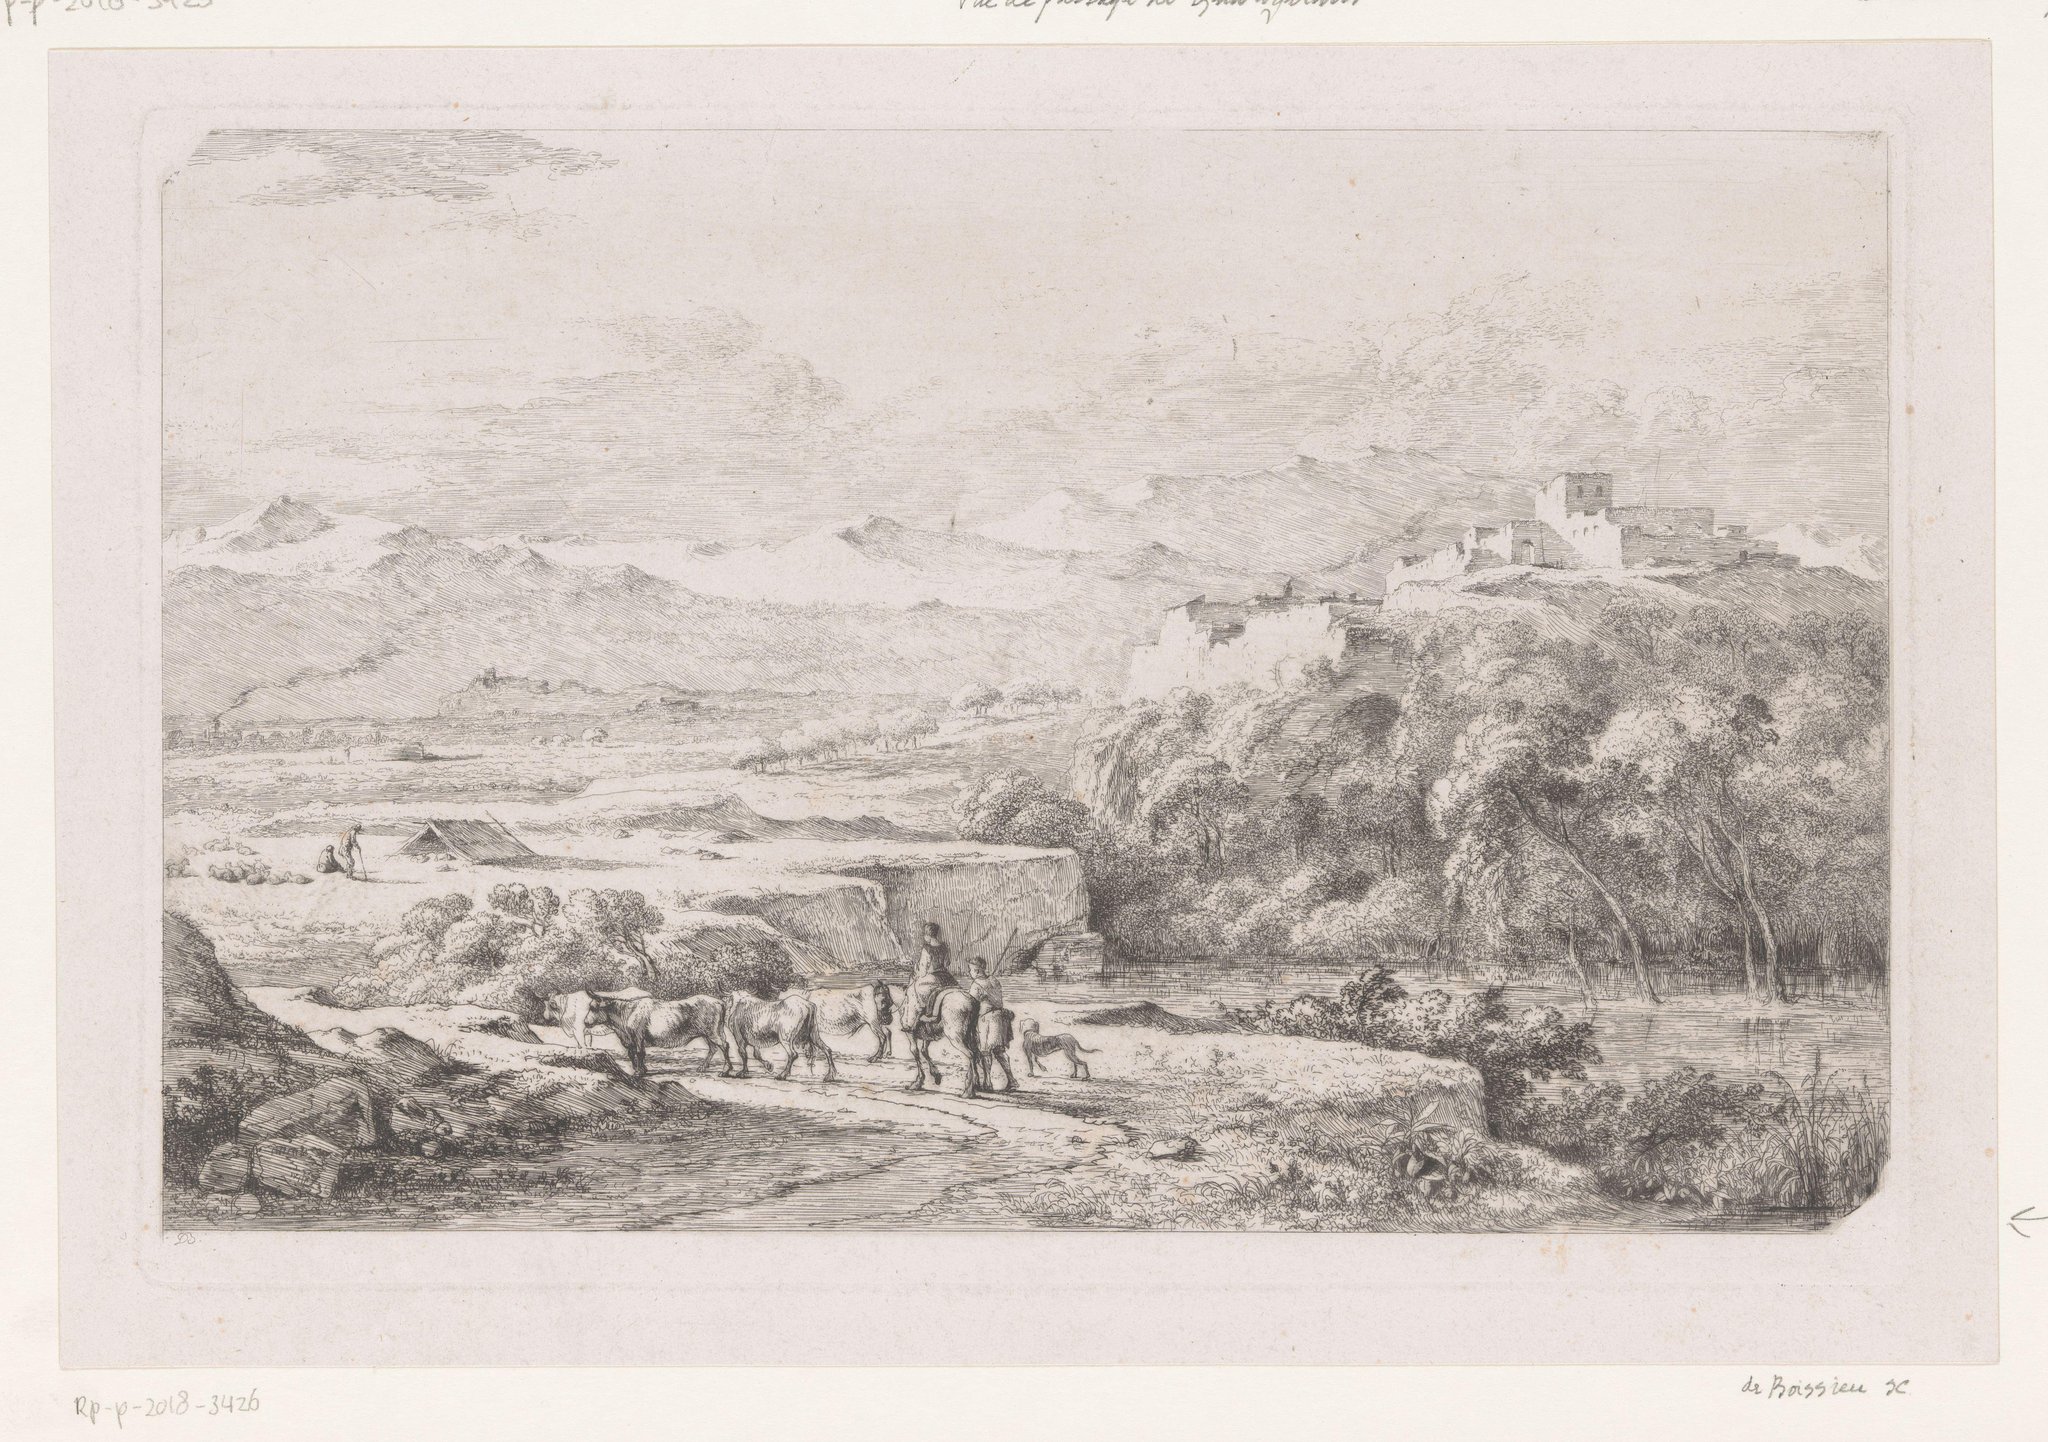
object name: print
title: Landschap met links twee figuren en vier koeien en rechts een ruïne op een heuvel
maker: jean jacques de boissieu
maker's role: draughtsman, print maker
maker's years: 1736-1810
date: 1762-1810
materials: paper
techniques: drypoint, etching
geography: france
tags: river, landscape with ruins